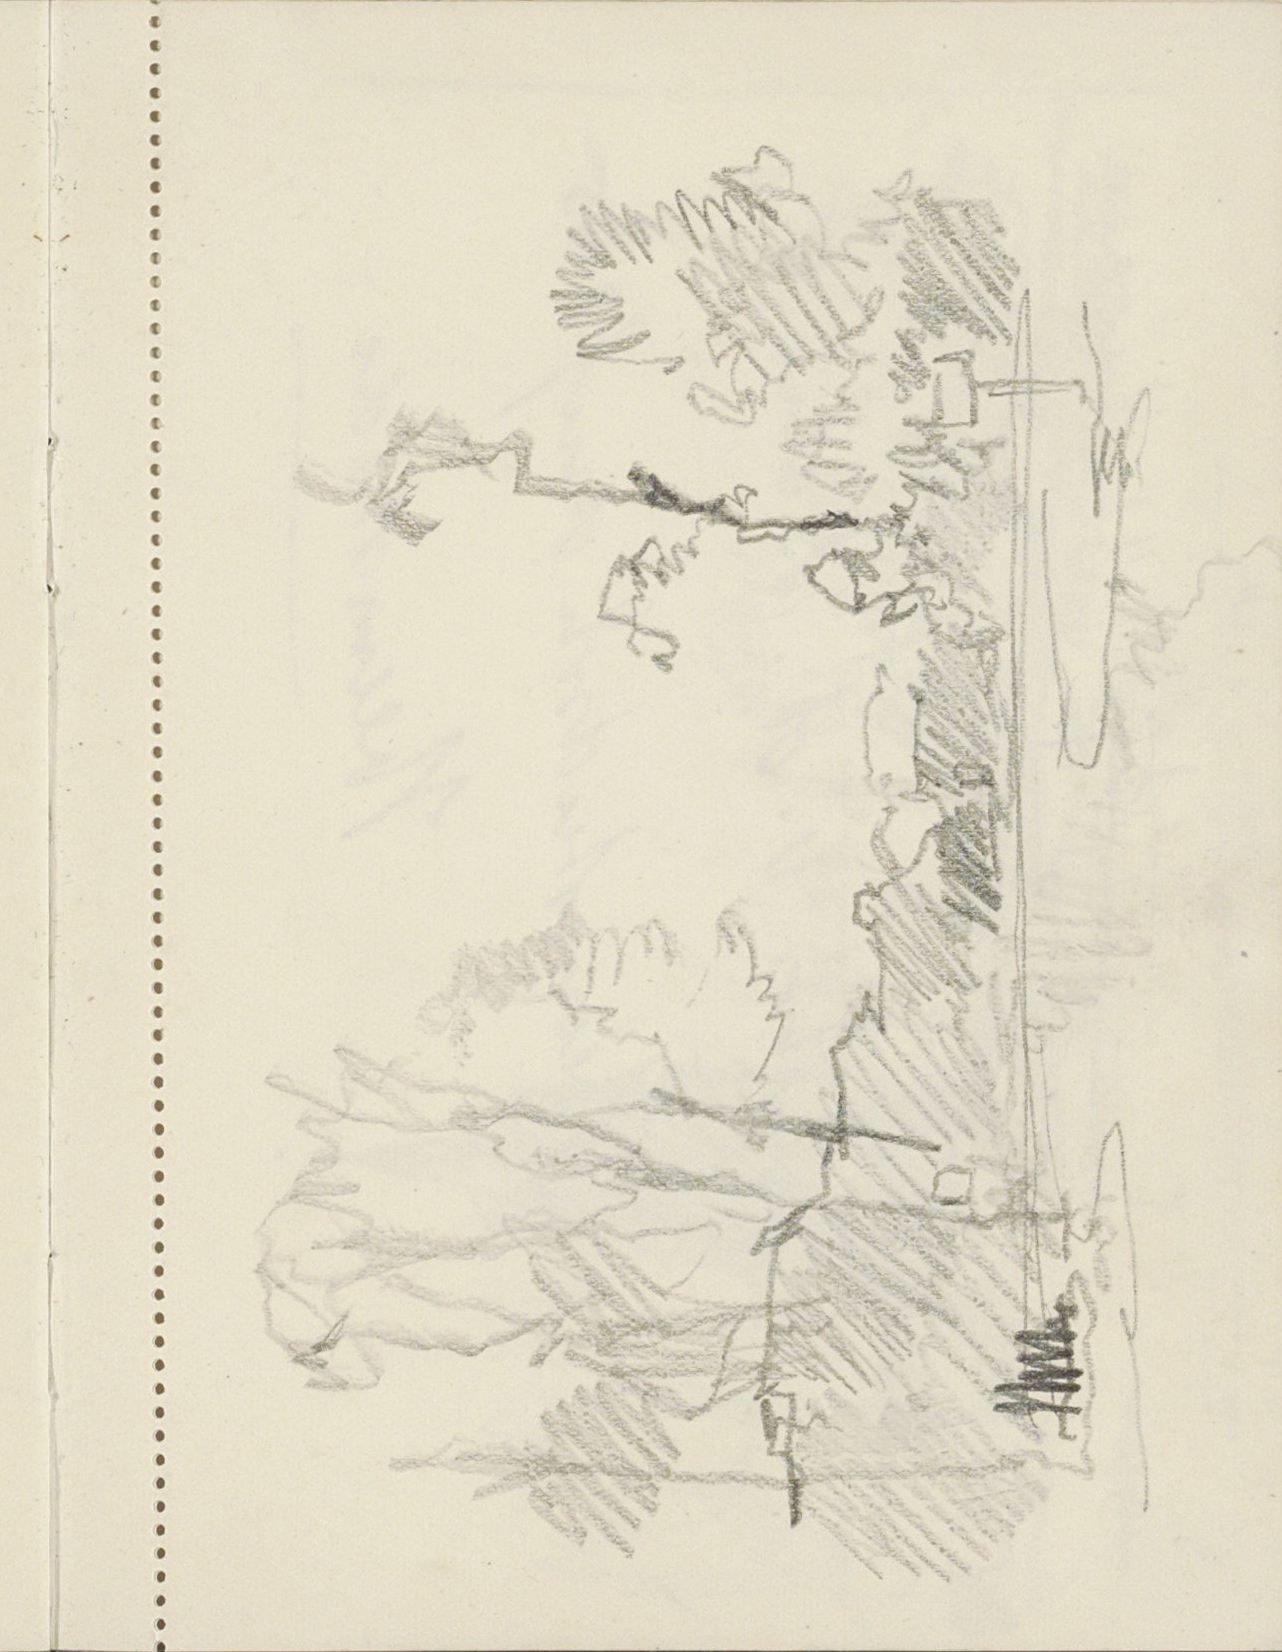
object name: sketchbook leaf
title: Landschap met bomen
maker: cornelis vreedenburgh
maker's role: draughtsman, print maker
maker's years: 1880-1946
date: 1890-1946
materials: paper, pencil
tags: landscapes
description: Blad 11 recto uit een schetsboek met 71 bladen.